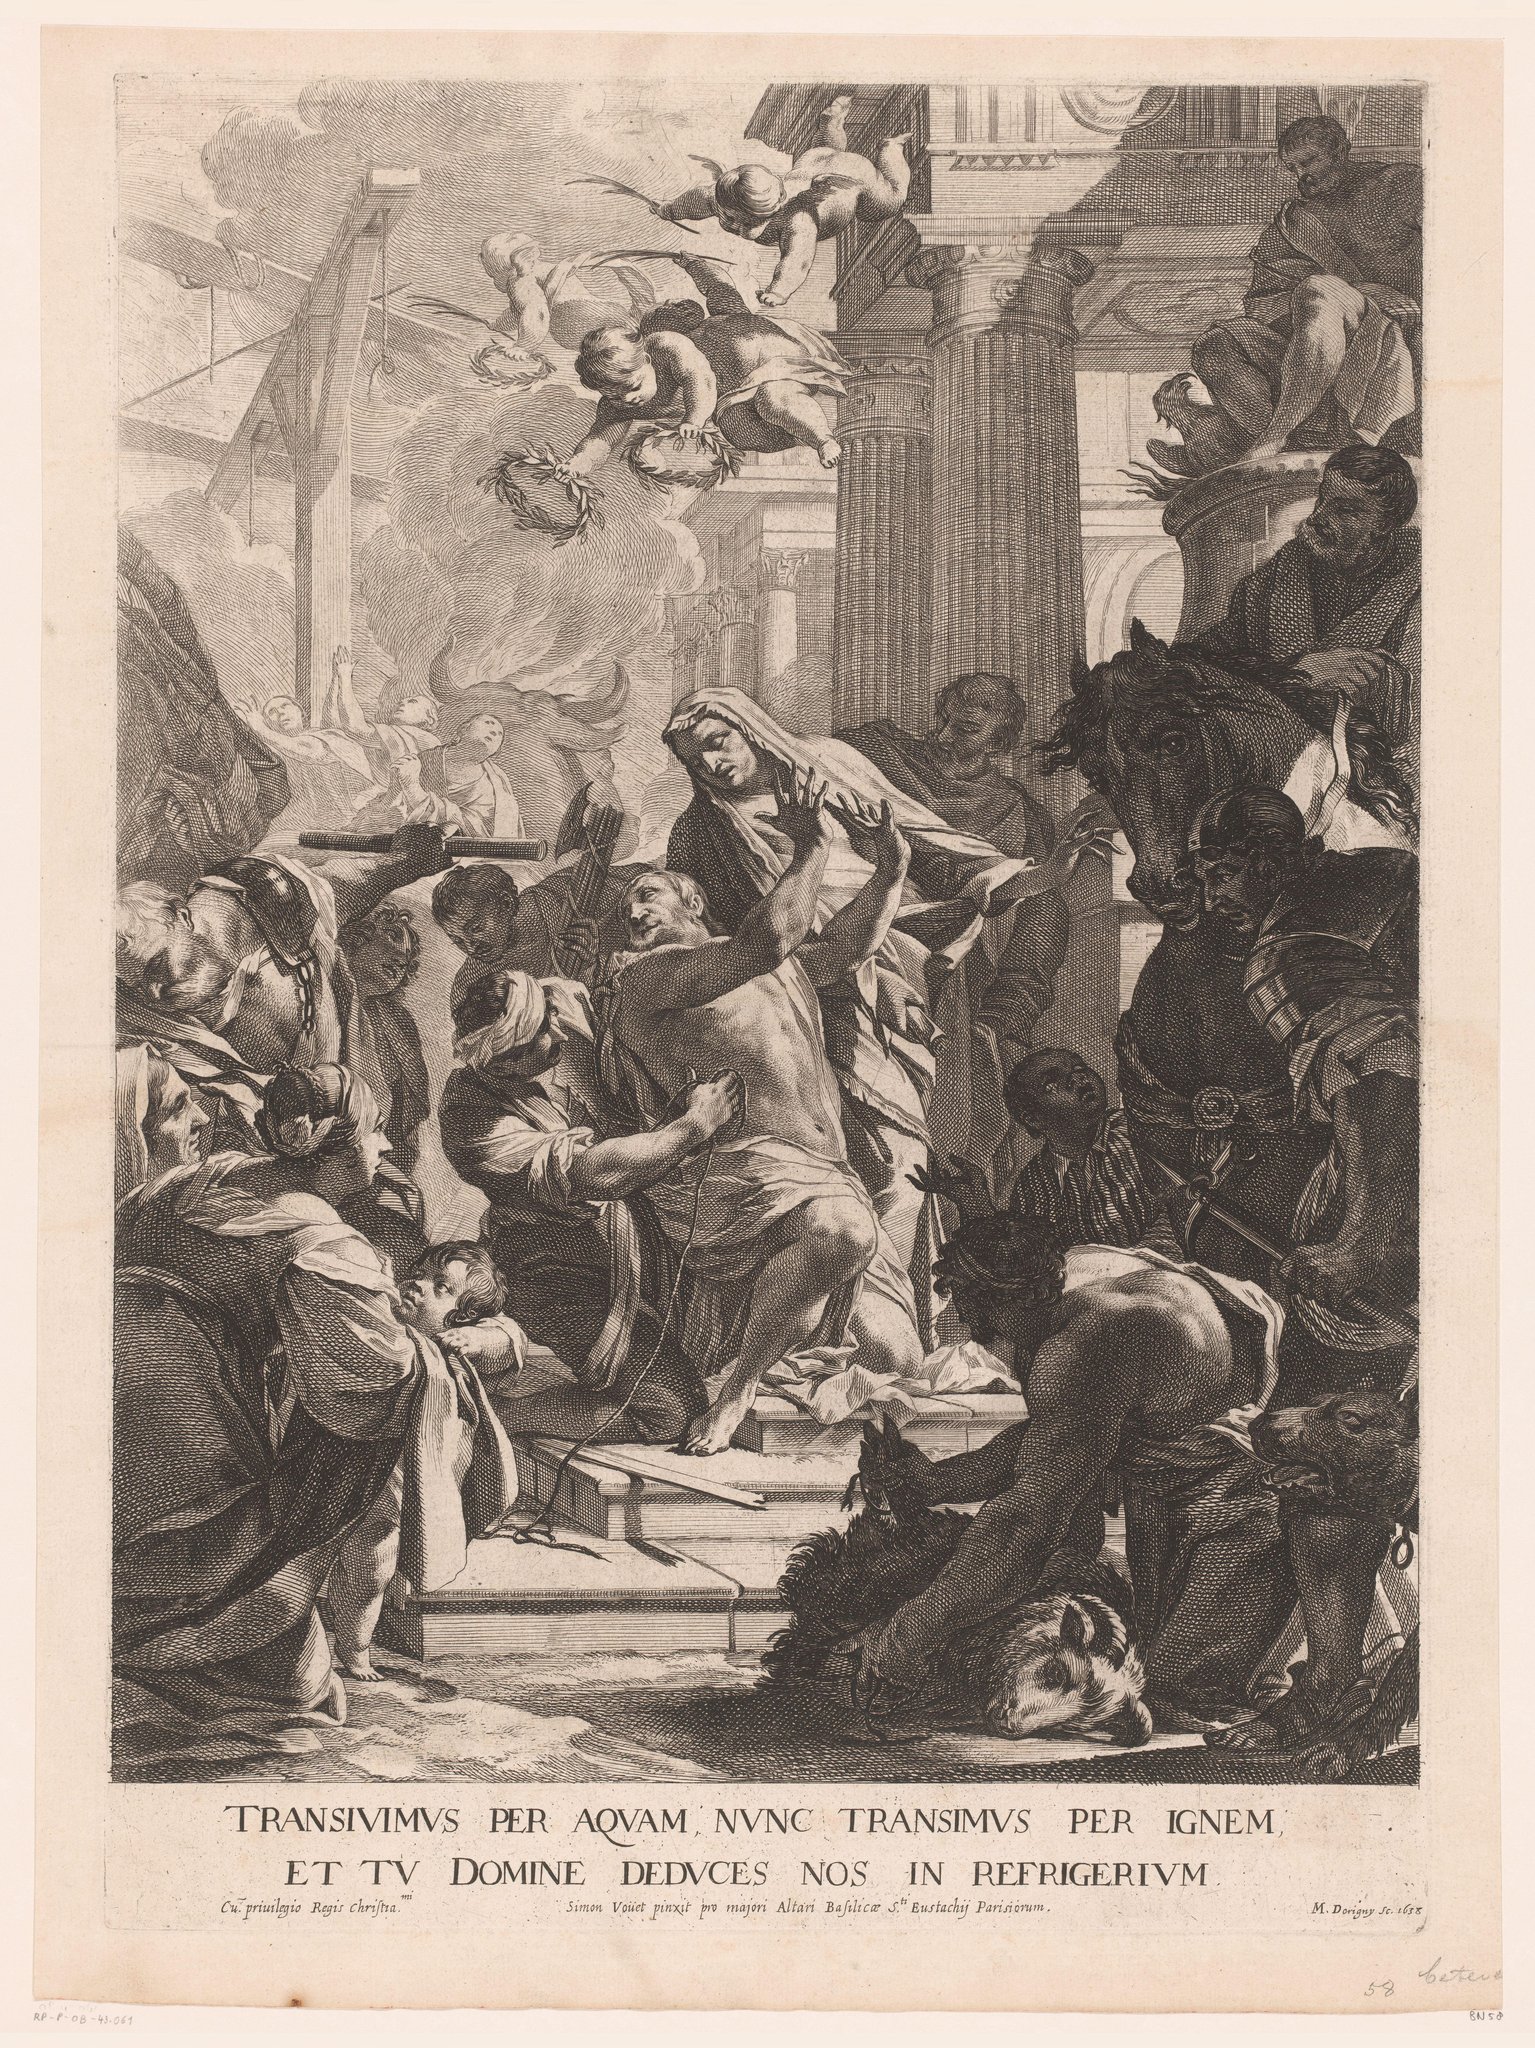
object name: print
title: Martelaarschap van Eustachius van Rome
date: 1638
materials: paper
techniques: engraving, etching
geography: france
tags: martyrdom, suffering, misfortune, death of st. eustace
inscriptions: collector's mark: Lugt 2228